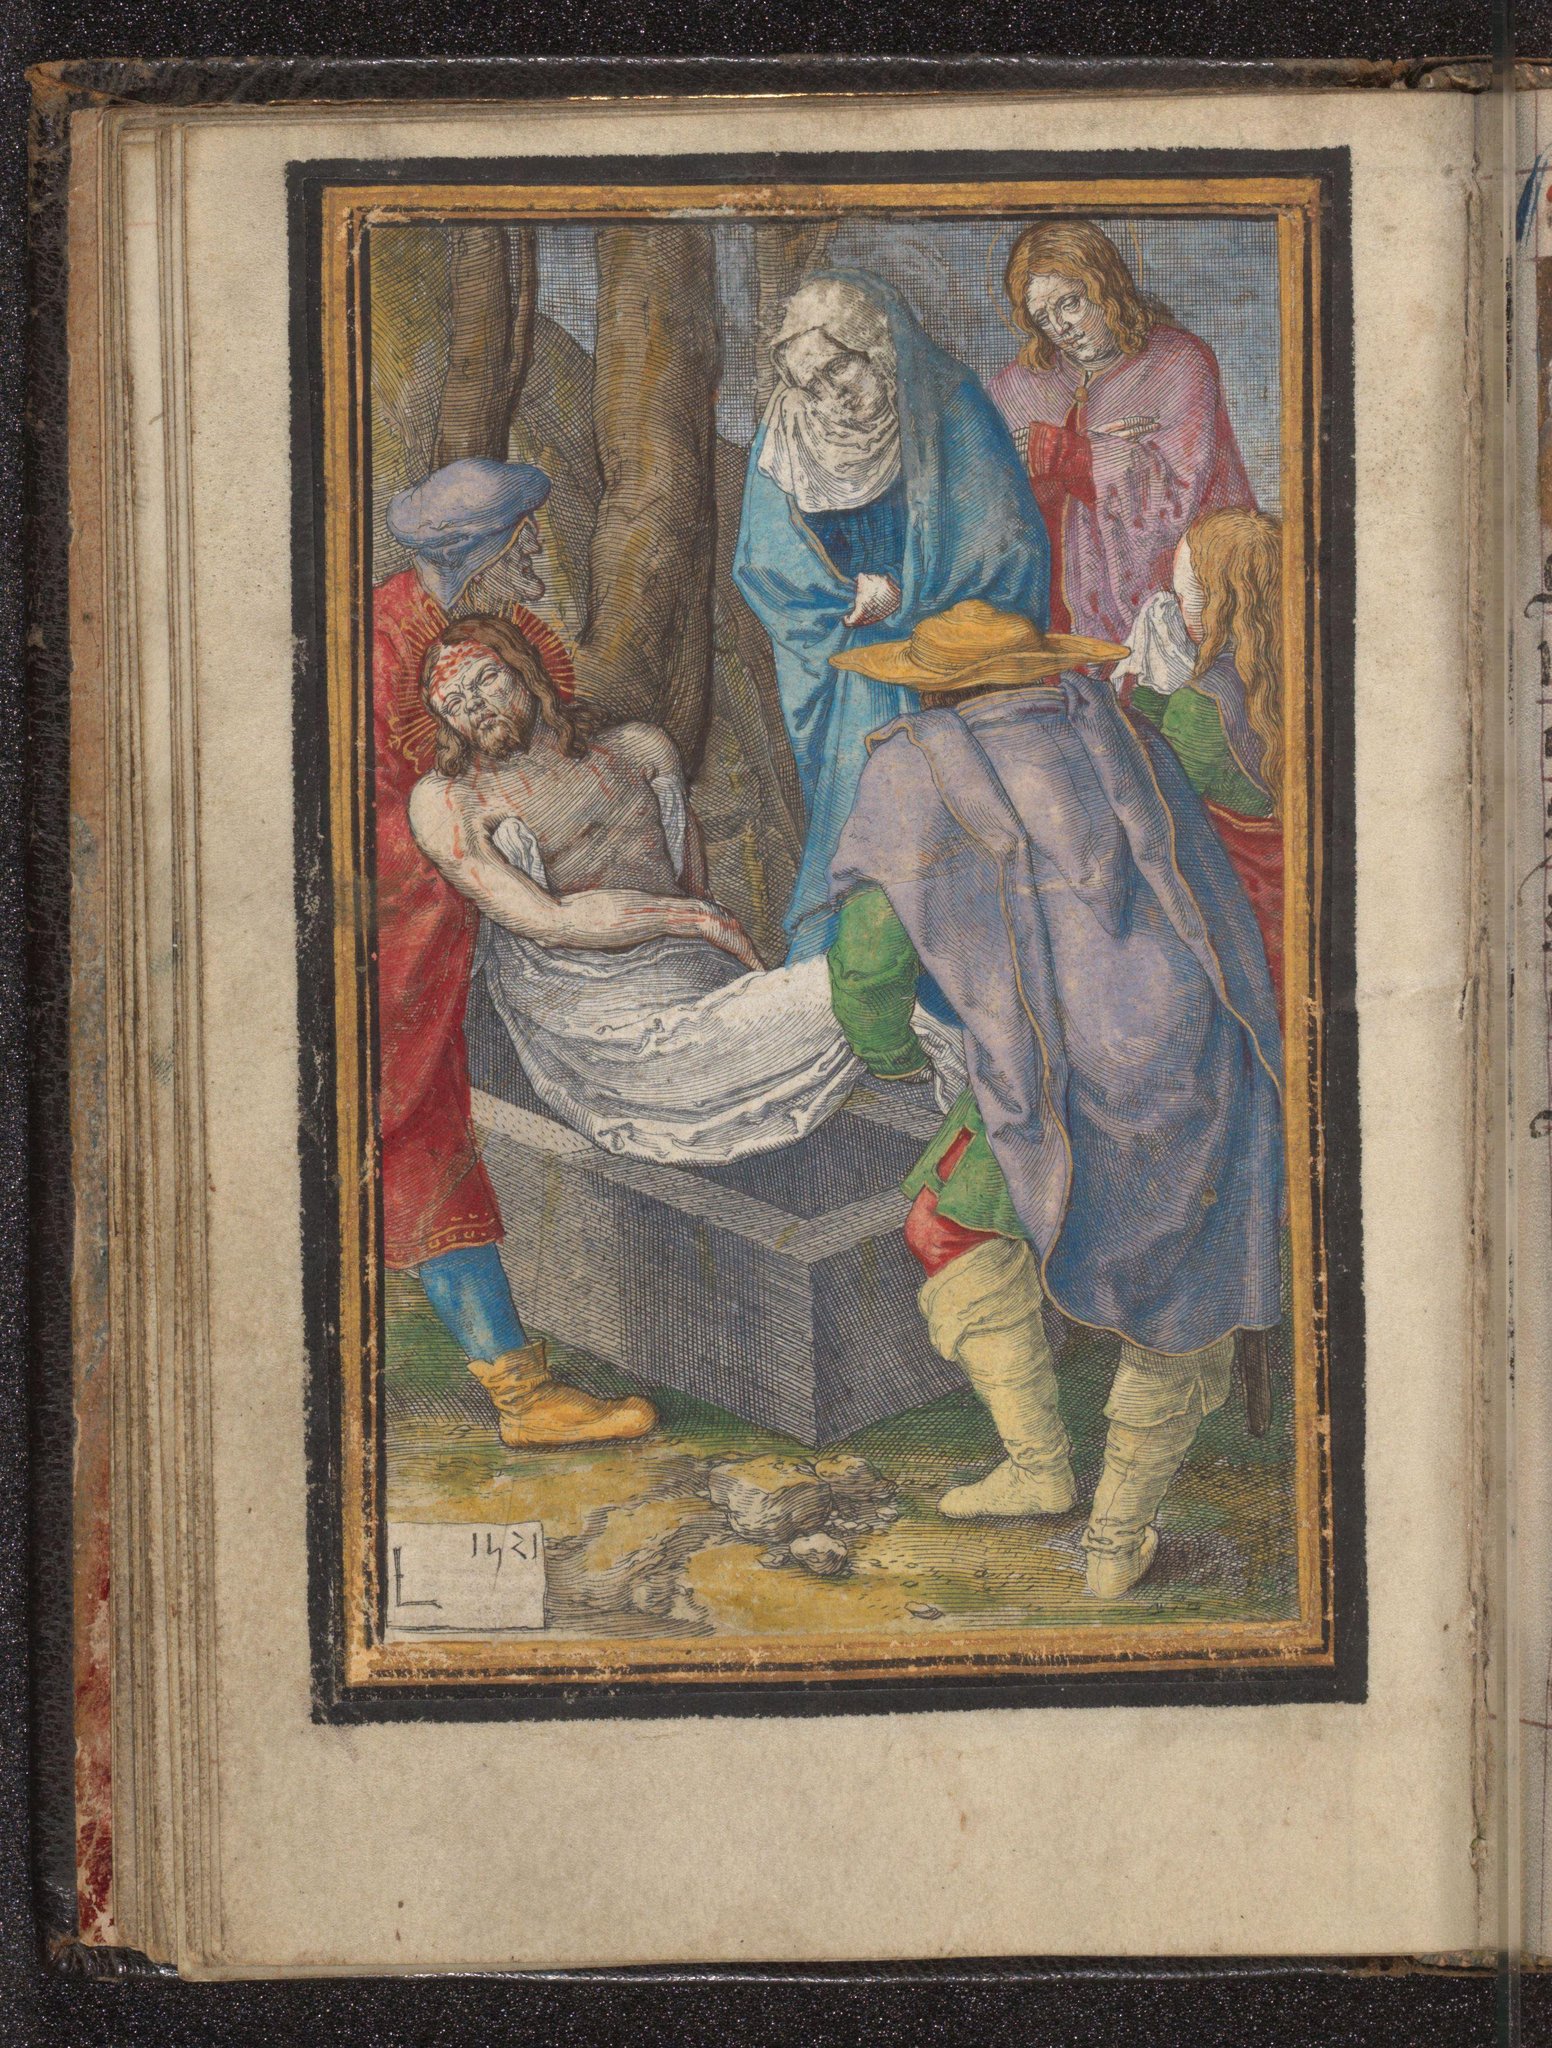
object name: print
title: Graflegging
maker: lucas van leyden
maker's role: draughtsman, painter, print maker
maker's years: 1494-1533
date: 1521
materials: paper, parchment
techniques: engraving, hand coloring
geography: leiden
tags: christ's entombment (possibly by angels)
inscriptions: date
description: Josef van Arimatea en Nikodemus tillen het lichaam van Christus in het graf. Op de achtergrond staan Maria, Johannes en Maria Magdalena. Deze prent maakt deel uit van een handgeschreven gebedenboek.